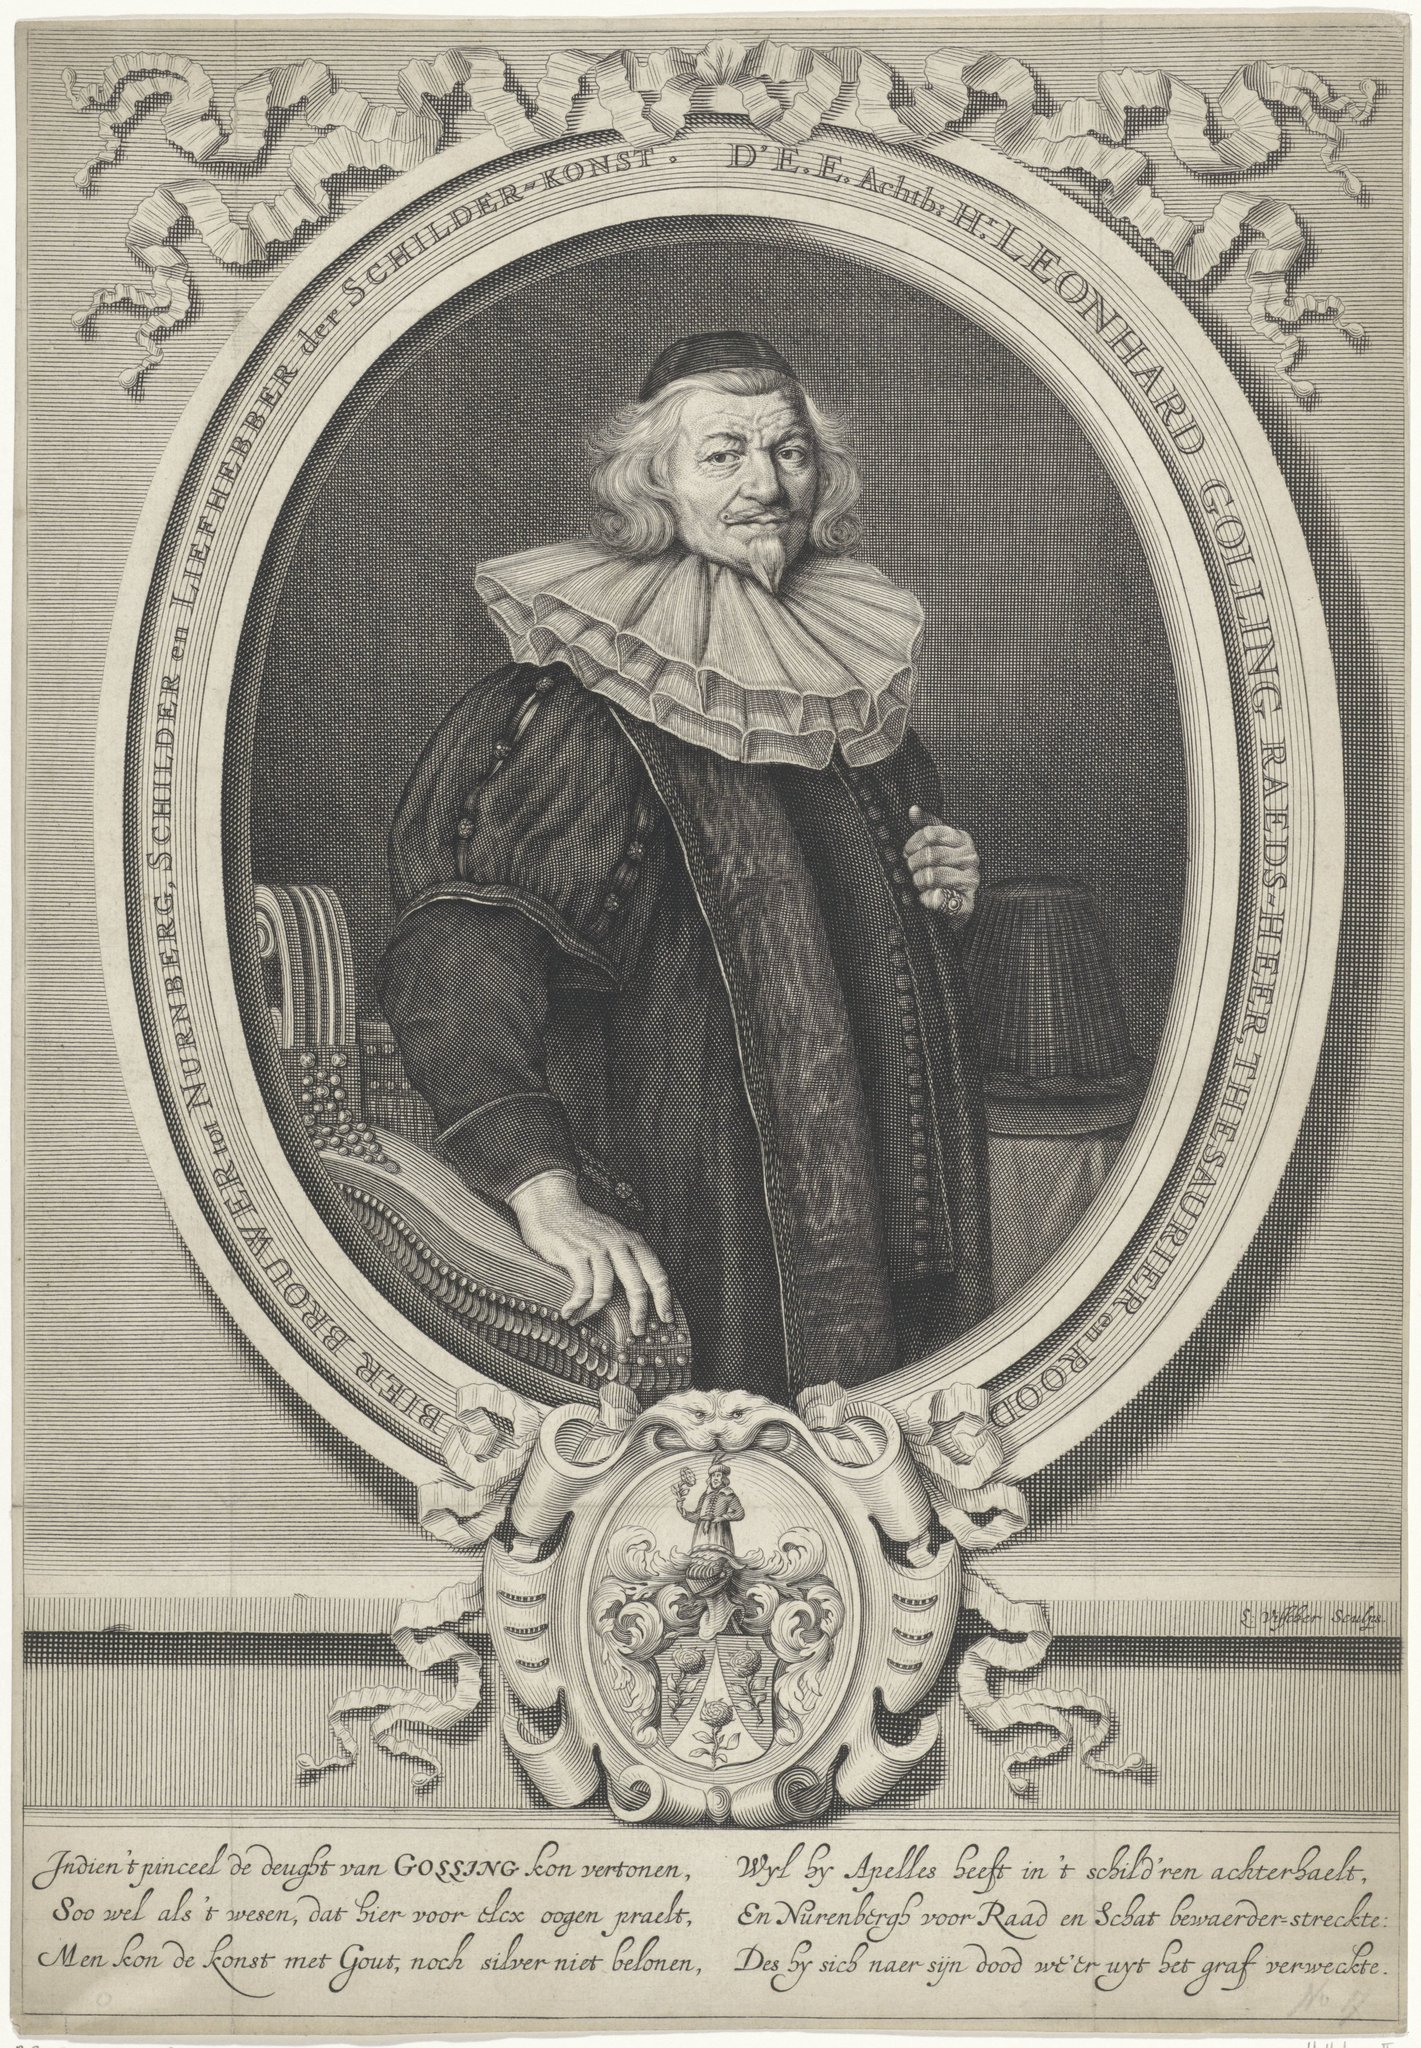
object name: print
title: Portret van Leonhard Golling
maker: lambert visscher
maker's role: draughtsman, print maker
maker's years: 1640-1679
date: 1677-1690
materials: paper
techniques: engraving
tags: painter, neck-gear ~ clothing (with name) (+ men's clothes), head-gear (with name), armorial bearing, heraldry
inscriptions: collector's mark: Lugt 2228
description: Leonhard Golling, raadsheer te Neurenberg. Golling is geportretteerd in staande houding en gekleed in een toga. Hij draagt een mutsje en zijn hoed ligt naast hem op een tafel.